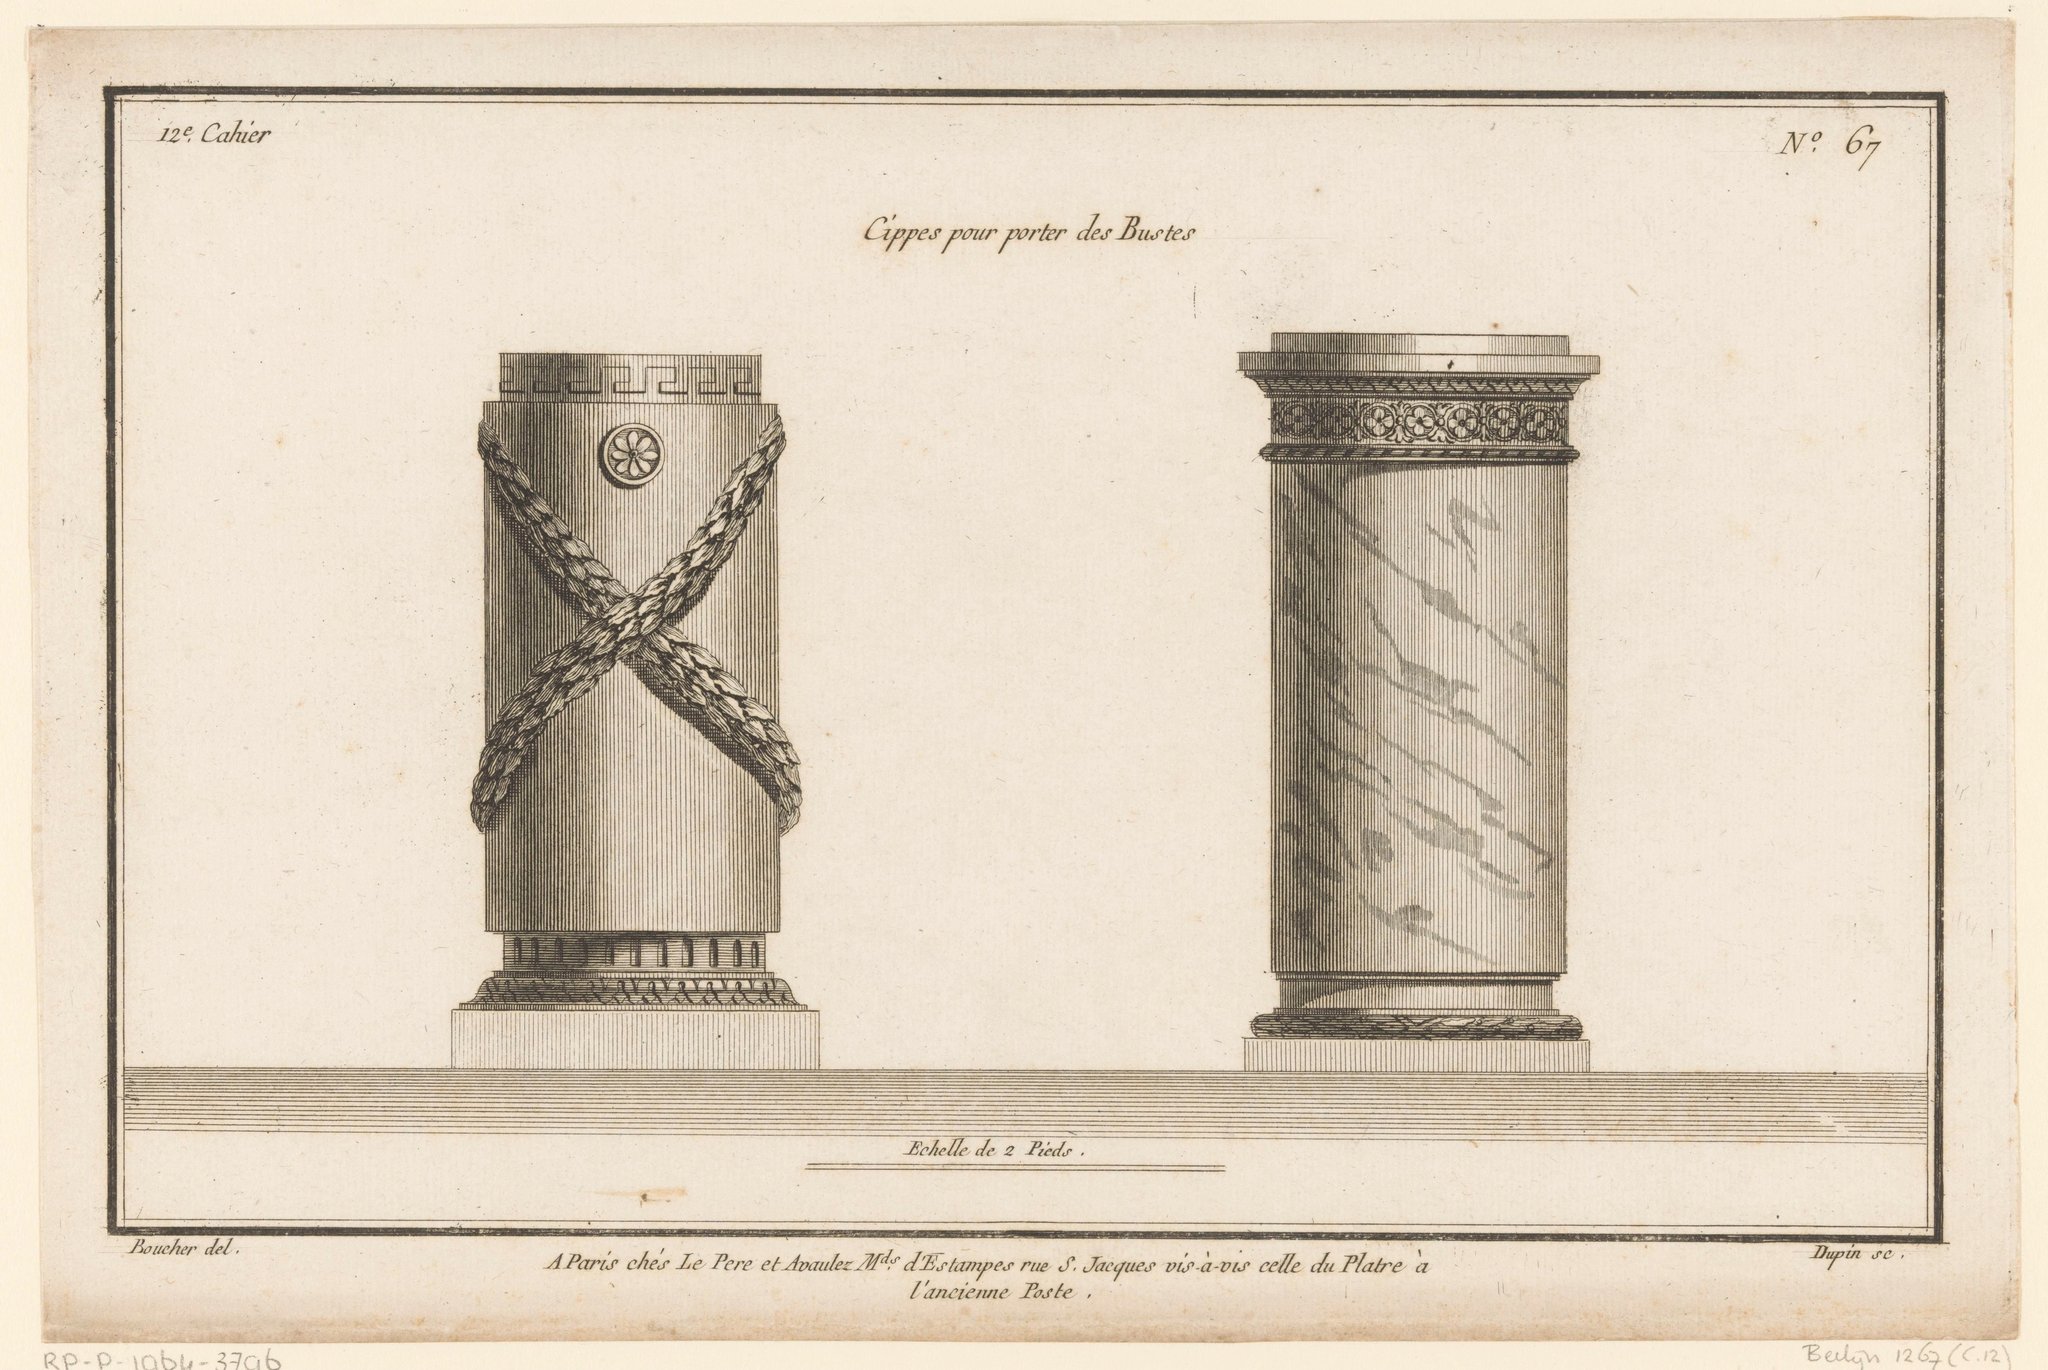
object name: print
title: Voetstukken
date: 1772-1779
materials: paper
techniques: engraving, etching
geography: paris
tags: column, pillar ~ architecture, pedestal of a piece of sculpture (perhaps in the form of a herm)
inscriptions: collector's mark: Lugt 2760, collector's mark: Lugt 2228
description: Twee geornamenteerde zuilen met bloemmotieven en links met guirlandes. Prentnummer 67.